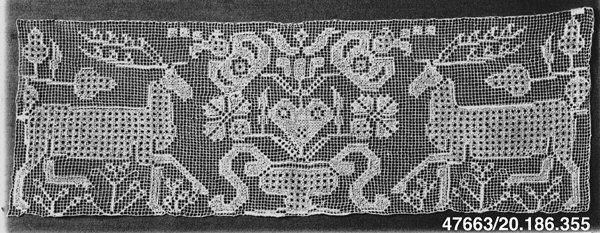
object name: panel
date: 1601-1700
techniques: embroidery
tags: deer,flowers